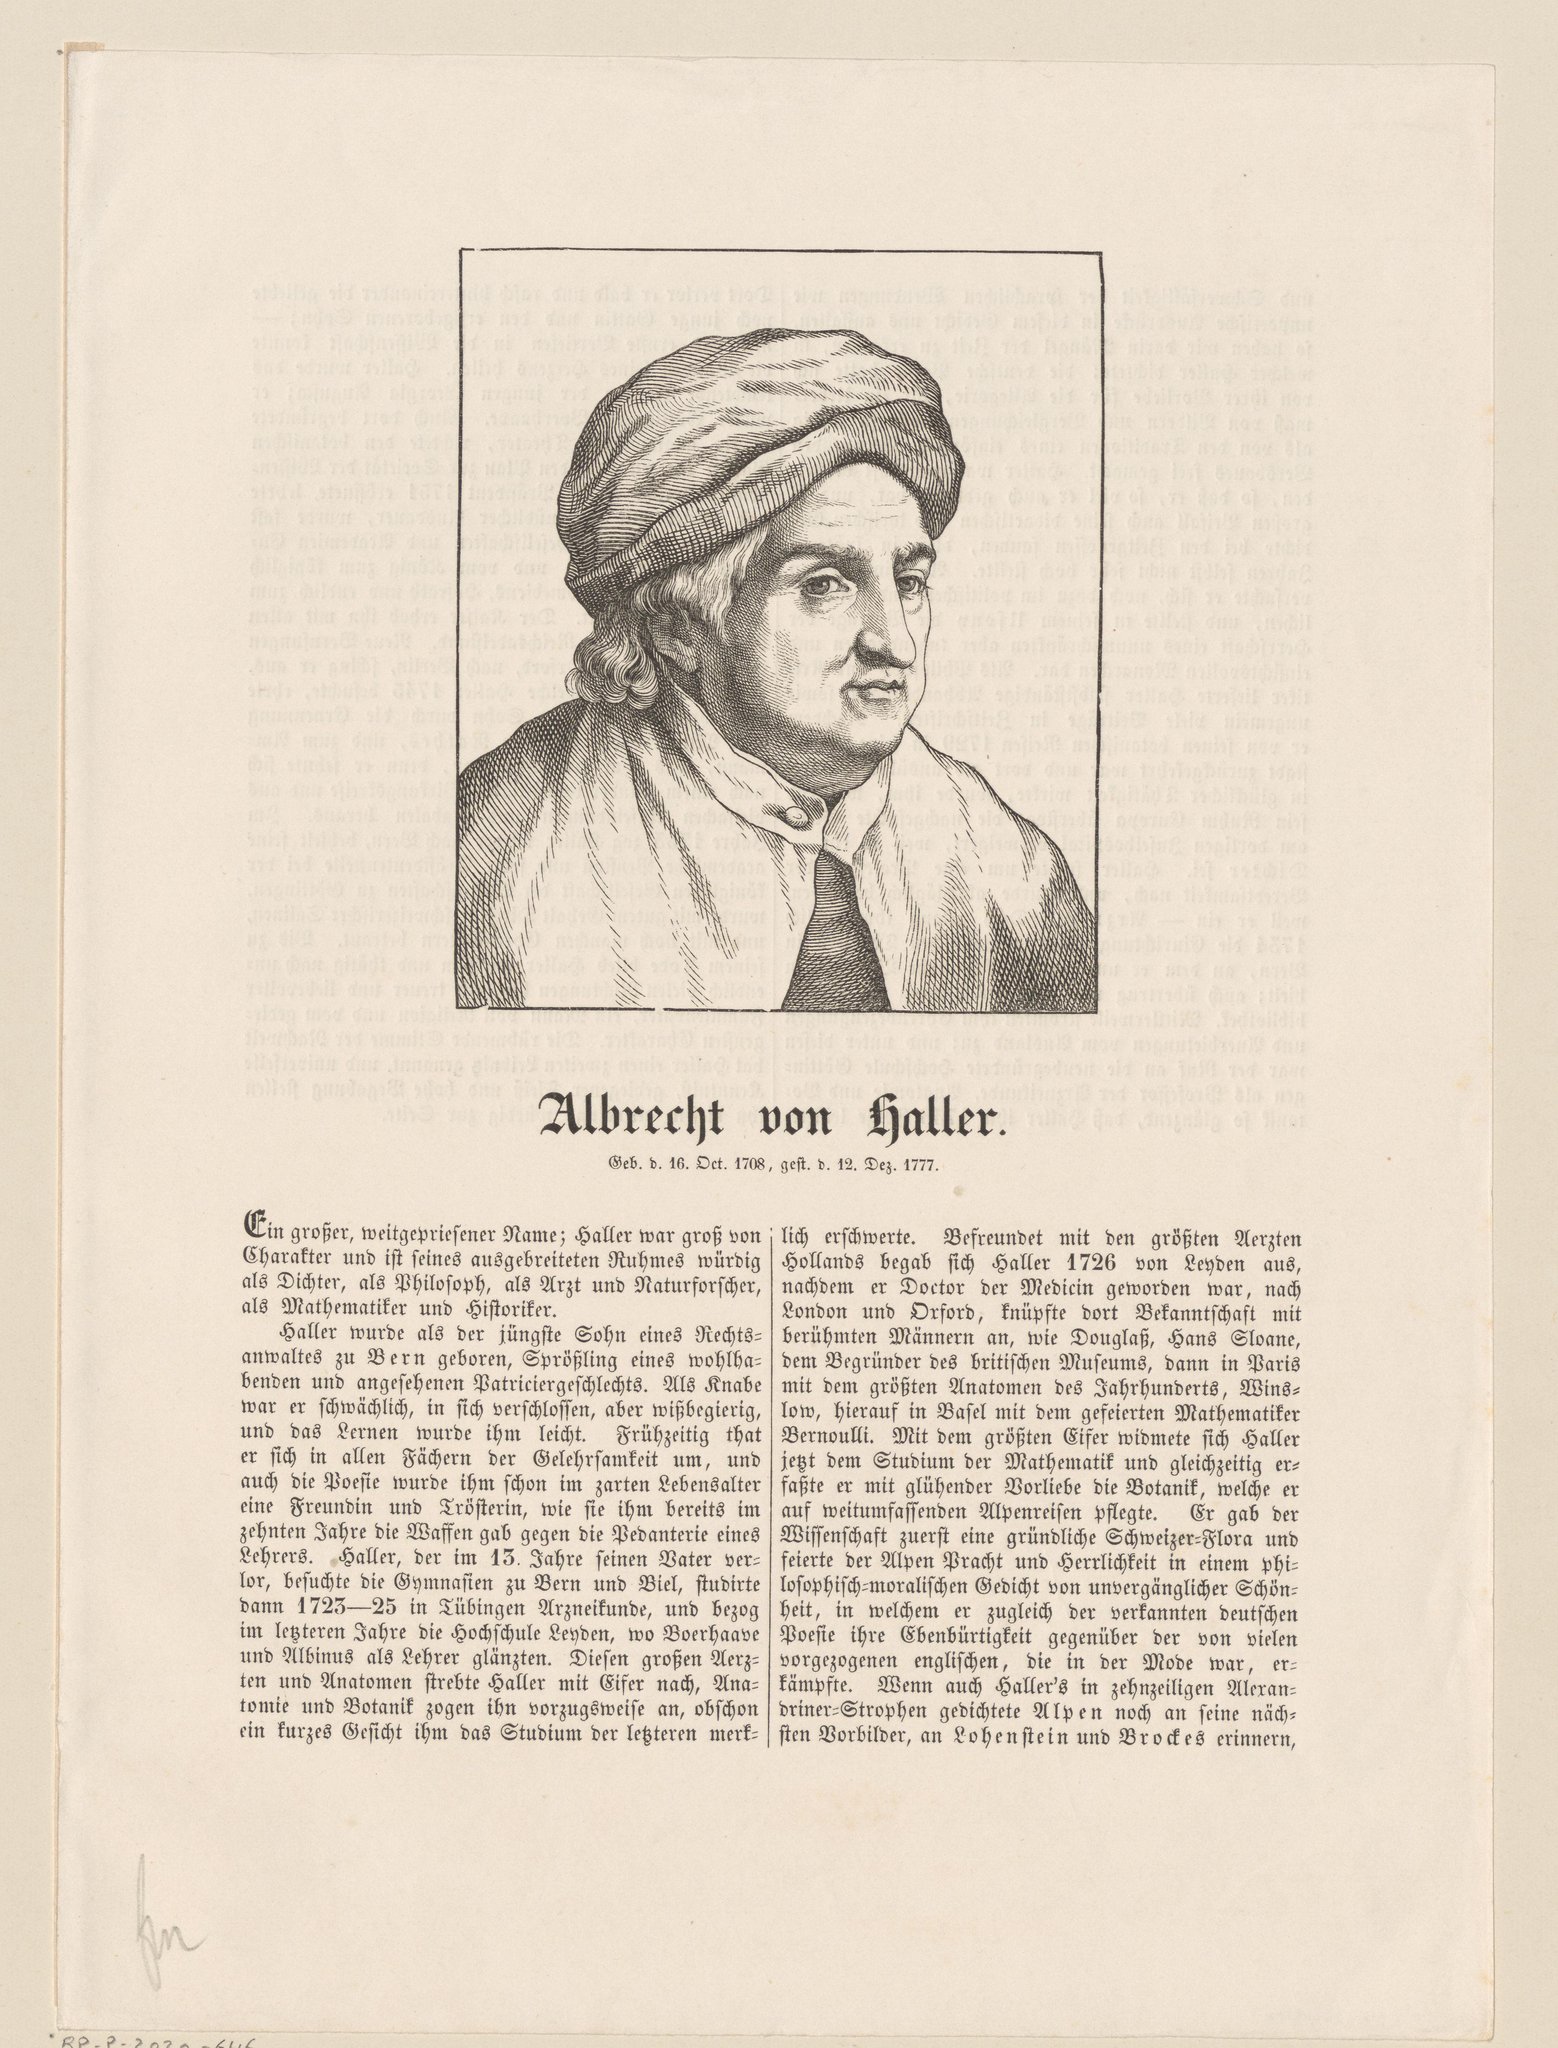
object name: print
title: Portret van Albrecht von Haller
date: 1854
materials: paper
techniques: letterpress printing, engraving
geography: leipzig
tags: physicist, historical persons, physician, doctor, writer, poet, author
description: Prent uit: Bechstein, Ludwig. Zweihundert deutsche Männer in Bildnissen und Lebensbeschreibungen. Leipzig: Georg Wigand, 1854.